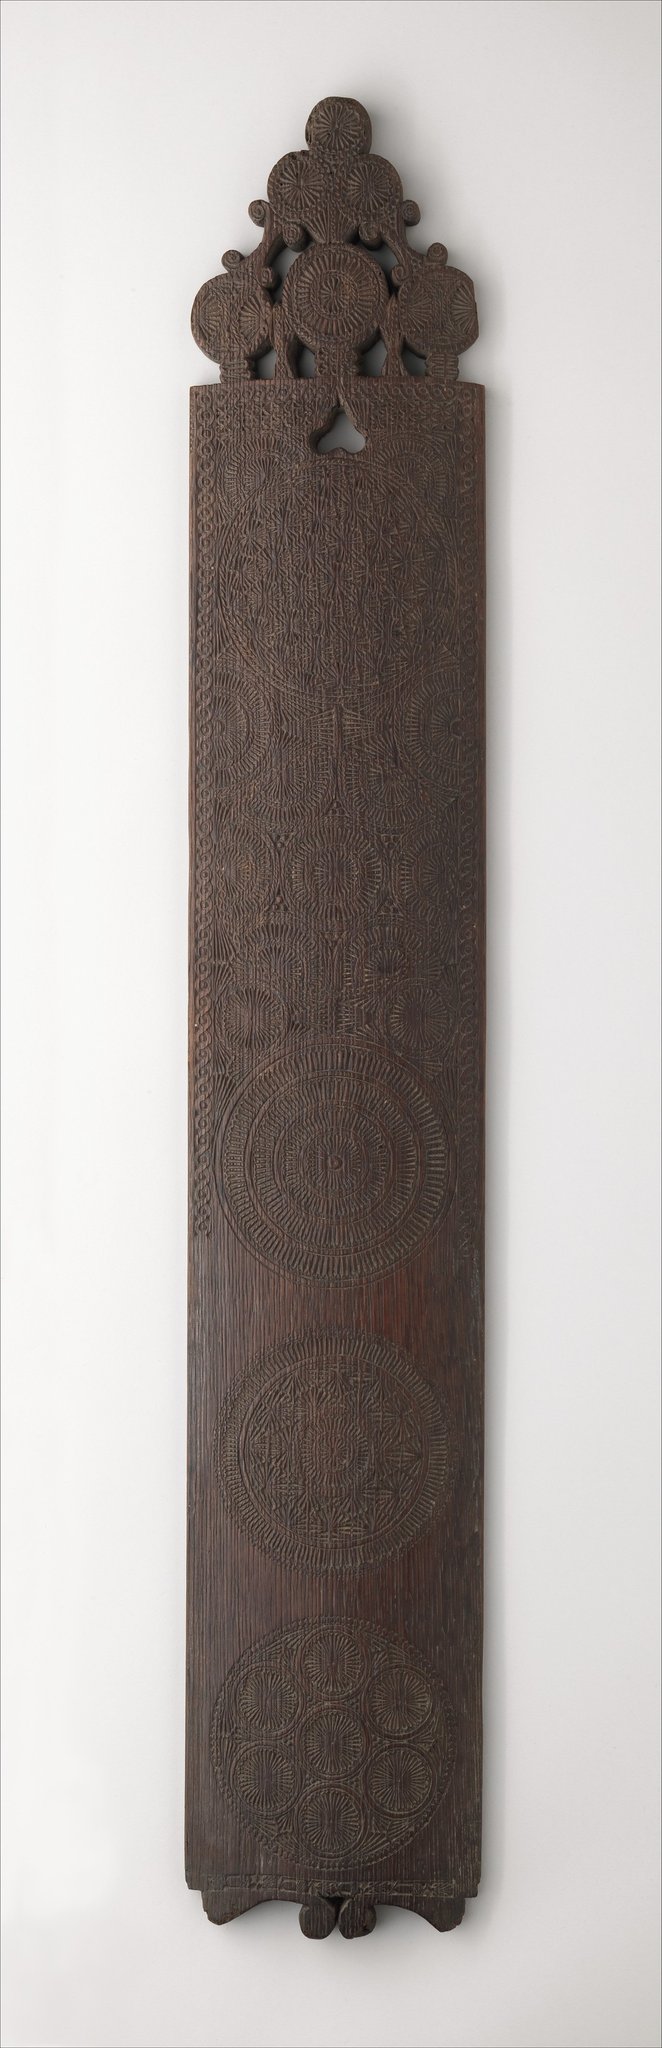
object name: mangle board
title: Mangle-board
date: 1701-1800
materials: wood